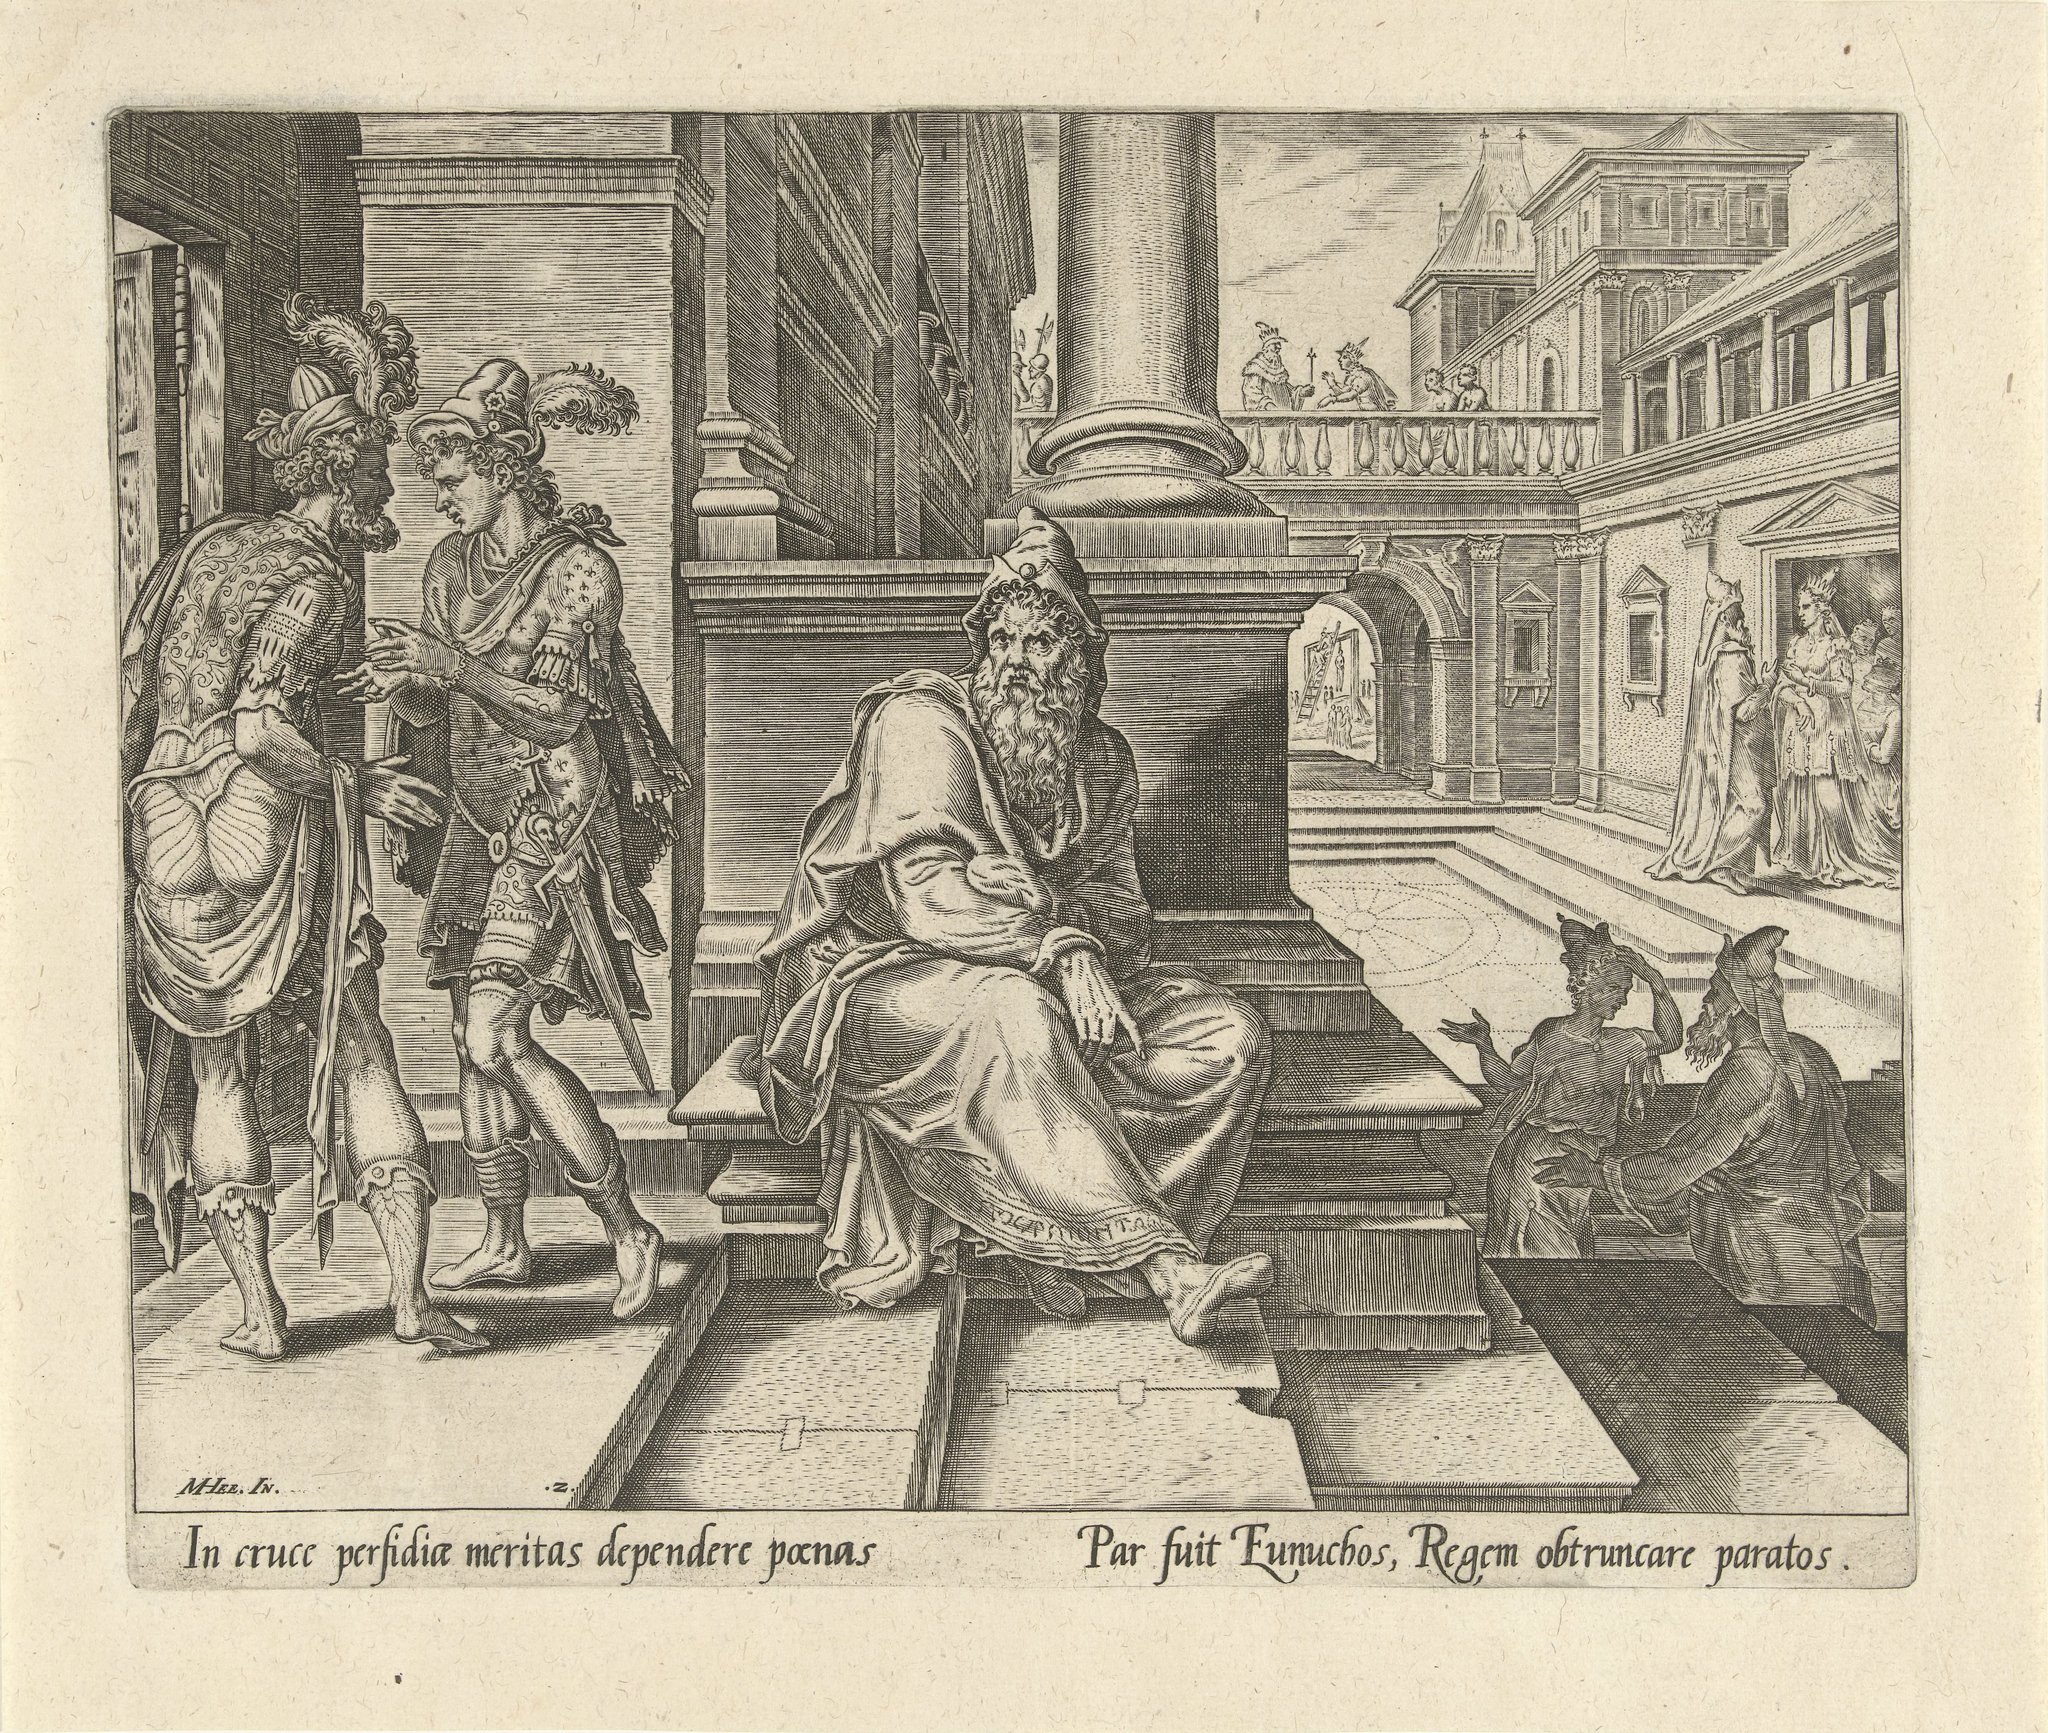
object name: print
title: Mordechai verijdelt een aanslag op koning Ahasveros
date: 1564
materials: paper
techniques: engraving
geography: haarlem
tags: mordecai prevents king ahasuerus' assassination (esther 2:21-23)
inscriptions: collector's mark: Lugt 2228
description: Mordechai hoort per toeval hoe twee lijfwachten van de koning een aanslag plannen. Rechts achter bij een deur vertelt Mordechai wat hij heeft gehoord aan koningin Ester. Op de achtergrond op een galerij waarschuwt Ester Ahasveros voor de lijfwachten.